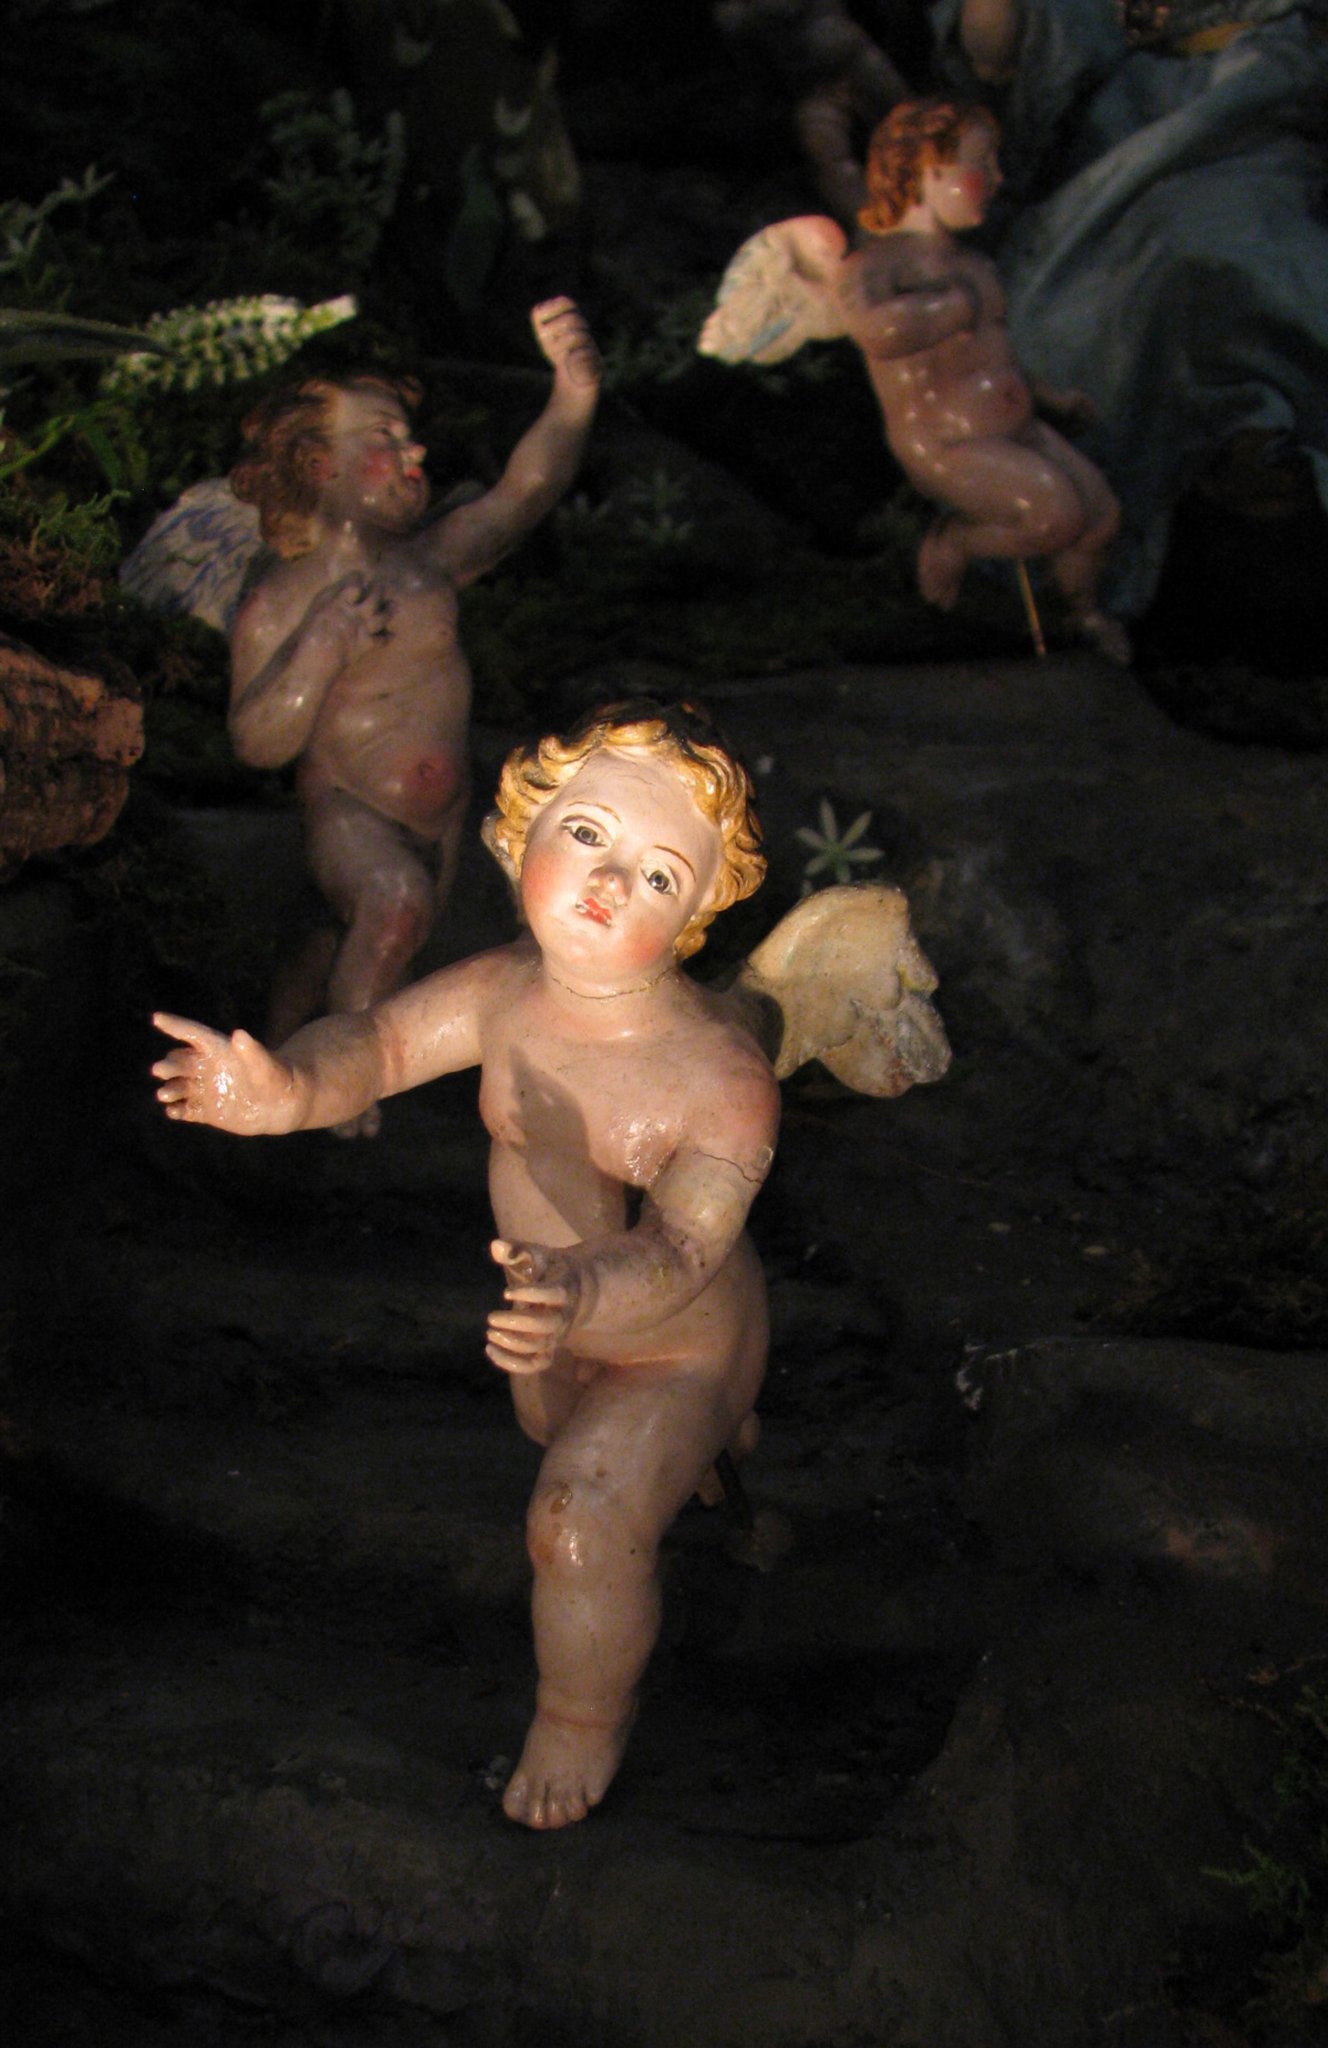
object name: crèche figure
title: Cherub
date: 1751-1800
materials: terracotta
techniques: polychrome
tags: angels